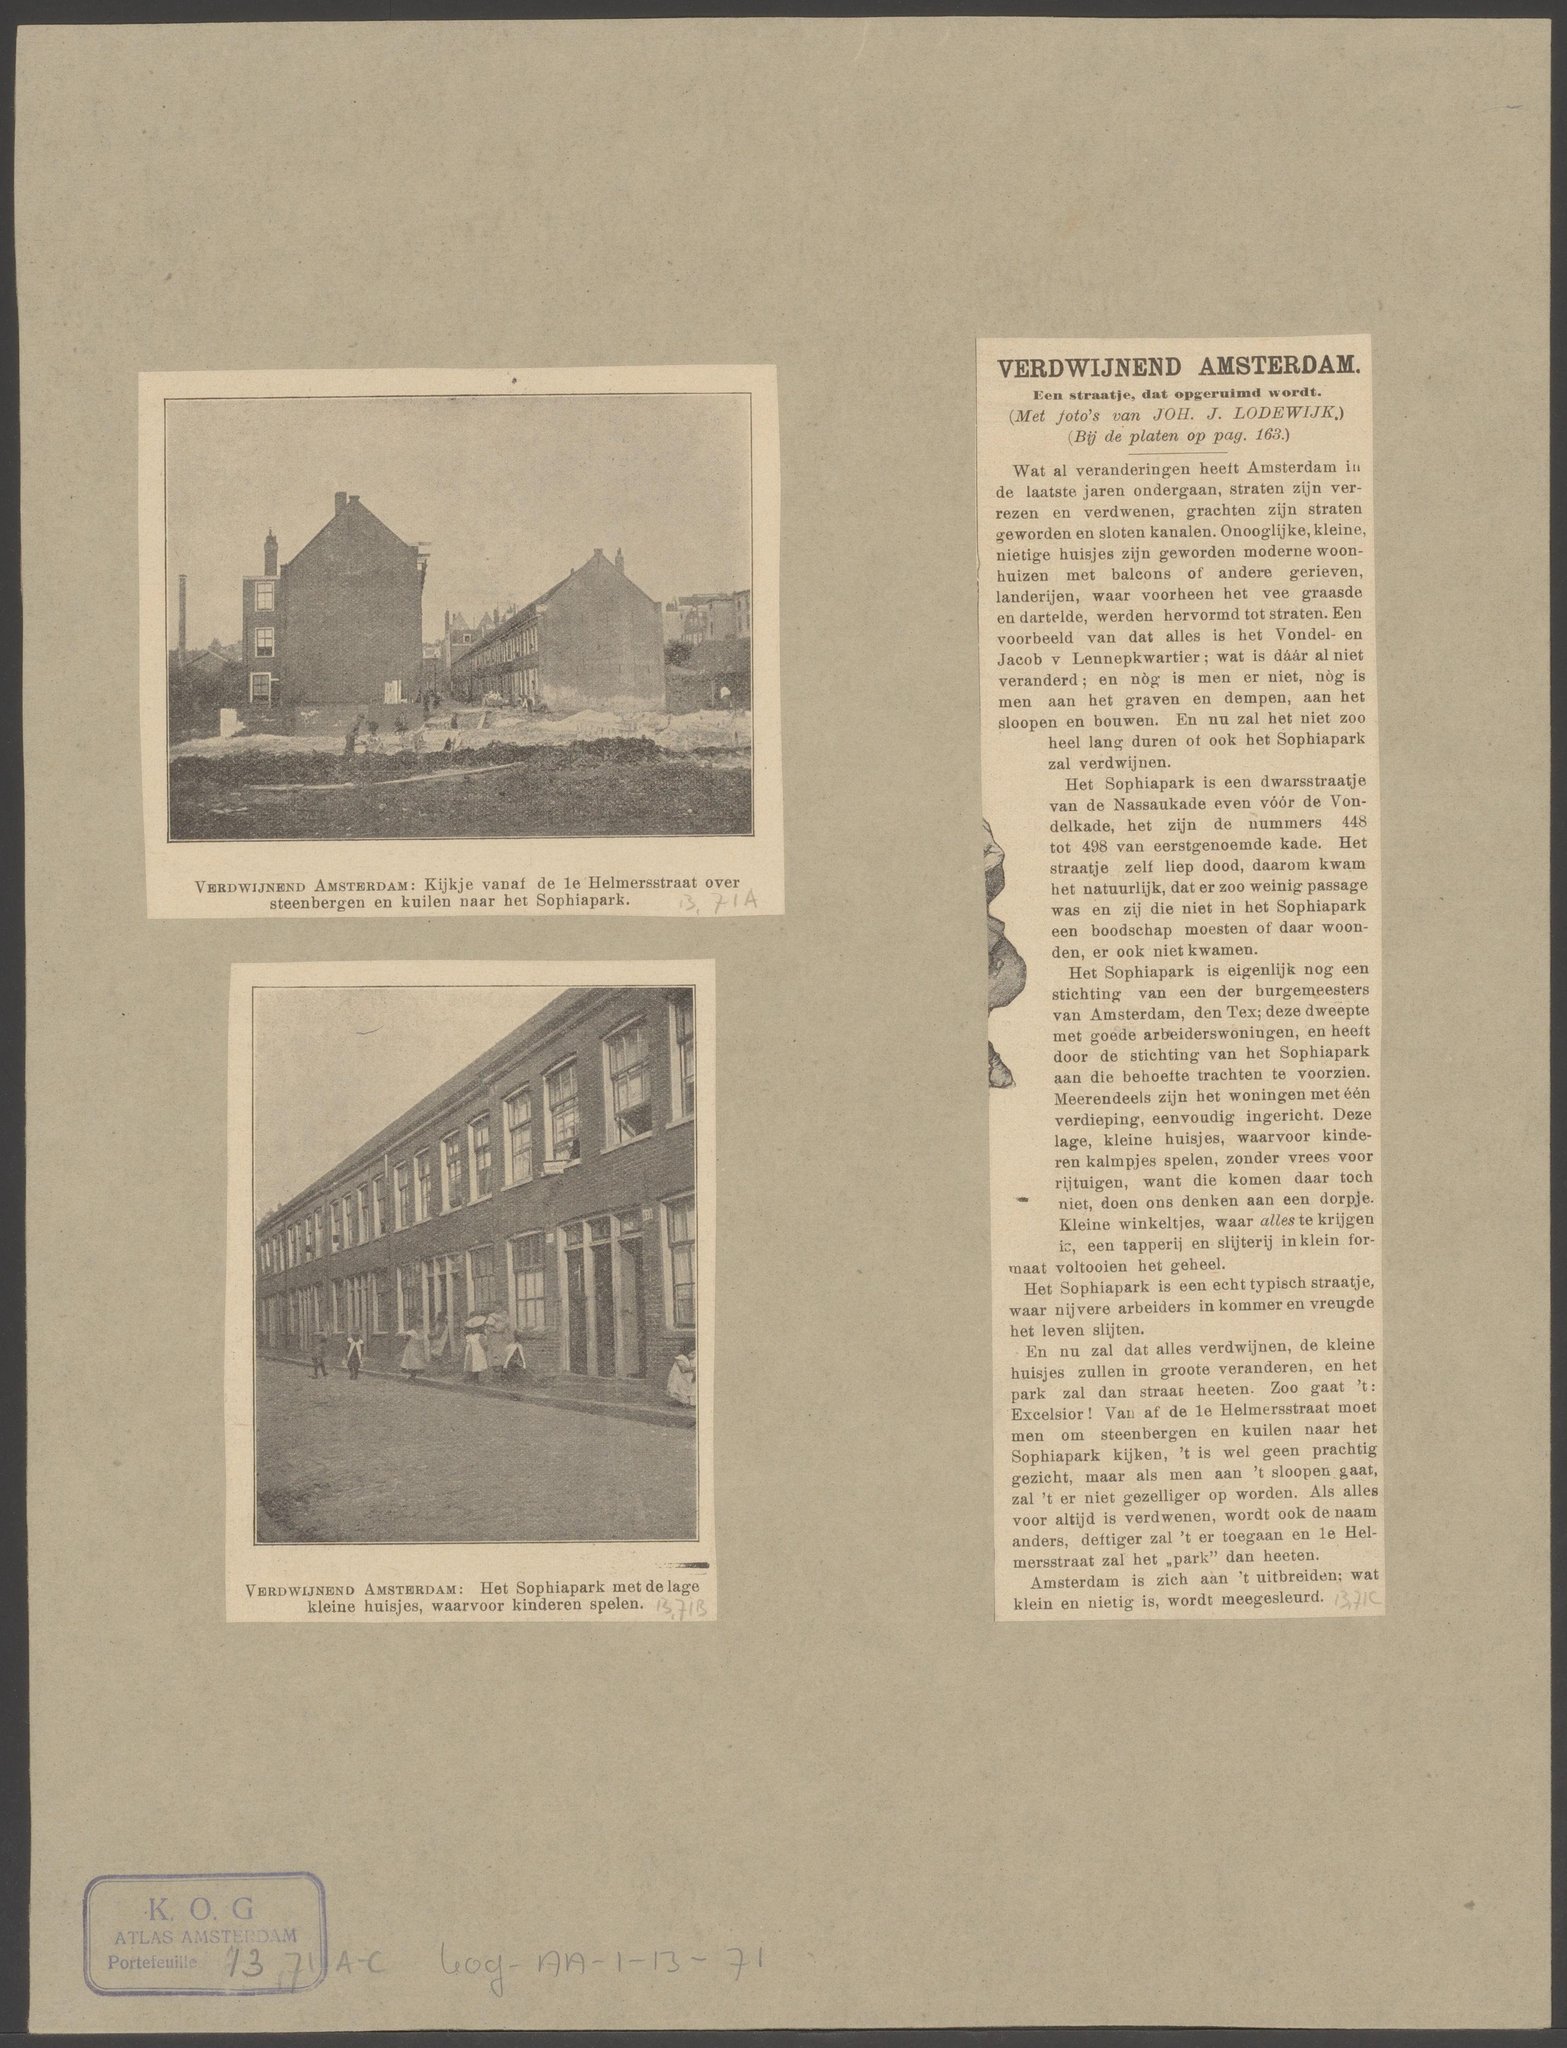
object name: photomechanical print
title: Gezichten bij het Sophiapark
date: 1882-1950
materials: paper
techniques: letterpress printing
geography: amsterdam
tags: city-view in general; 'veduta', the usual house or row of houses, building-site, street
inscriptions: collector's mark: ‘13,71’ Lugt 1641b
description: Onderwerpsrubriek binnen de Atlas Amsterdam: Slatuinenpad, Sloterkade, Slootstraat, Slijkstraat, Snoekjesgracht, Sophiapark, Spaarndammerdijk, Spiegelgracht, Spinhuissteeg, Spui, Spuistraat (ook lage Erf), Staalstraat, Stadhouderskade, Steenpad, Stroomarkt.